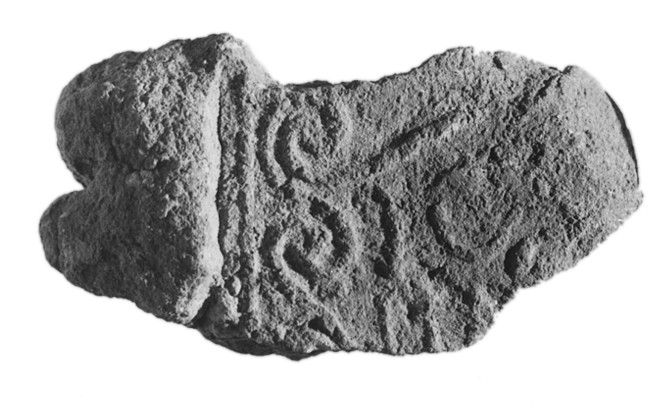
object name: sealing fragment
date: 2030-1640 BCE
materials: clay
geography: egypt